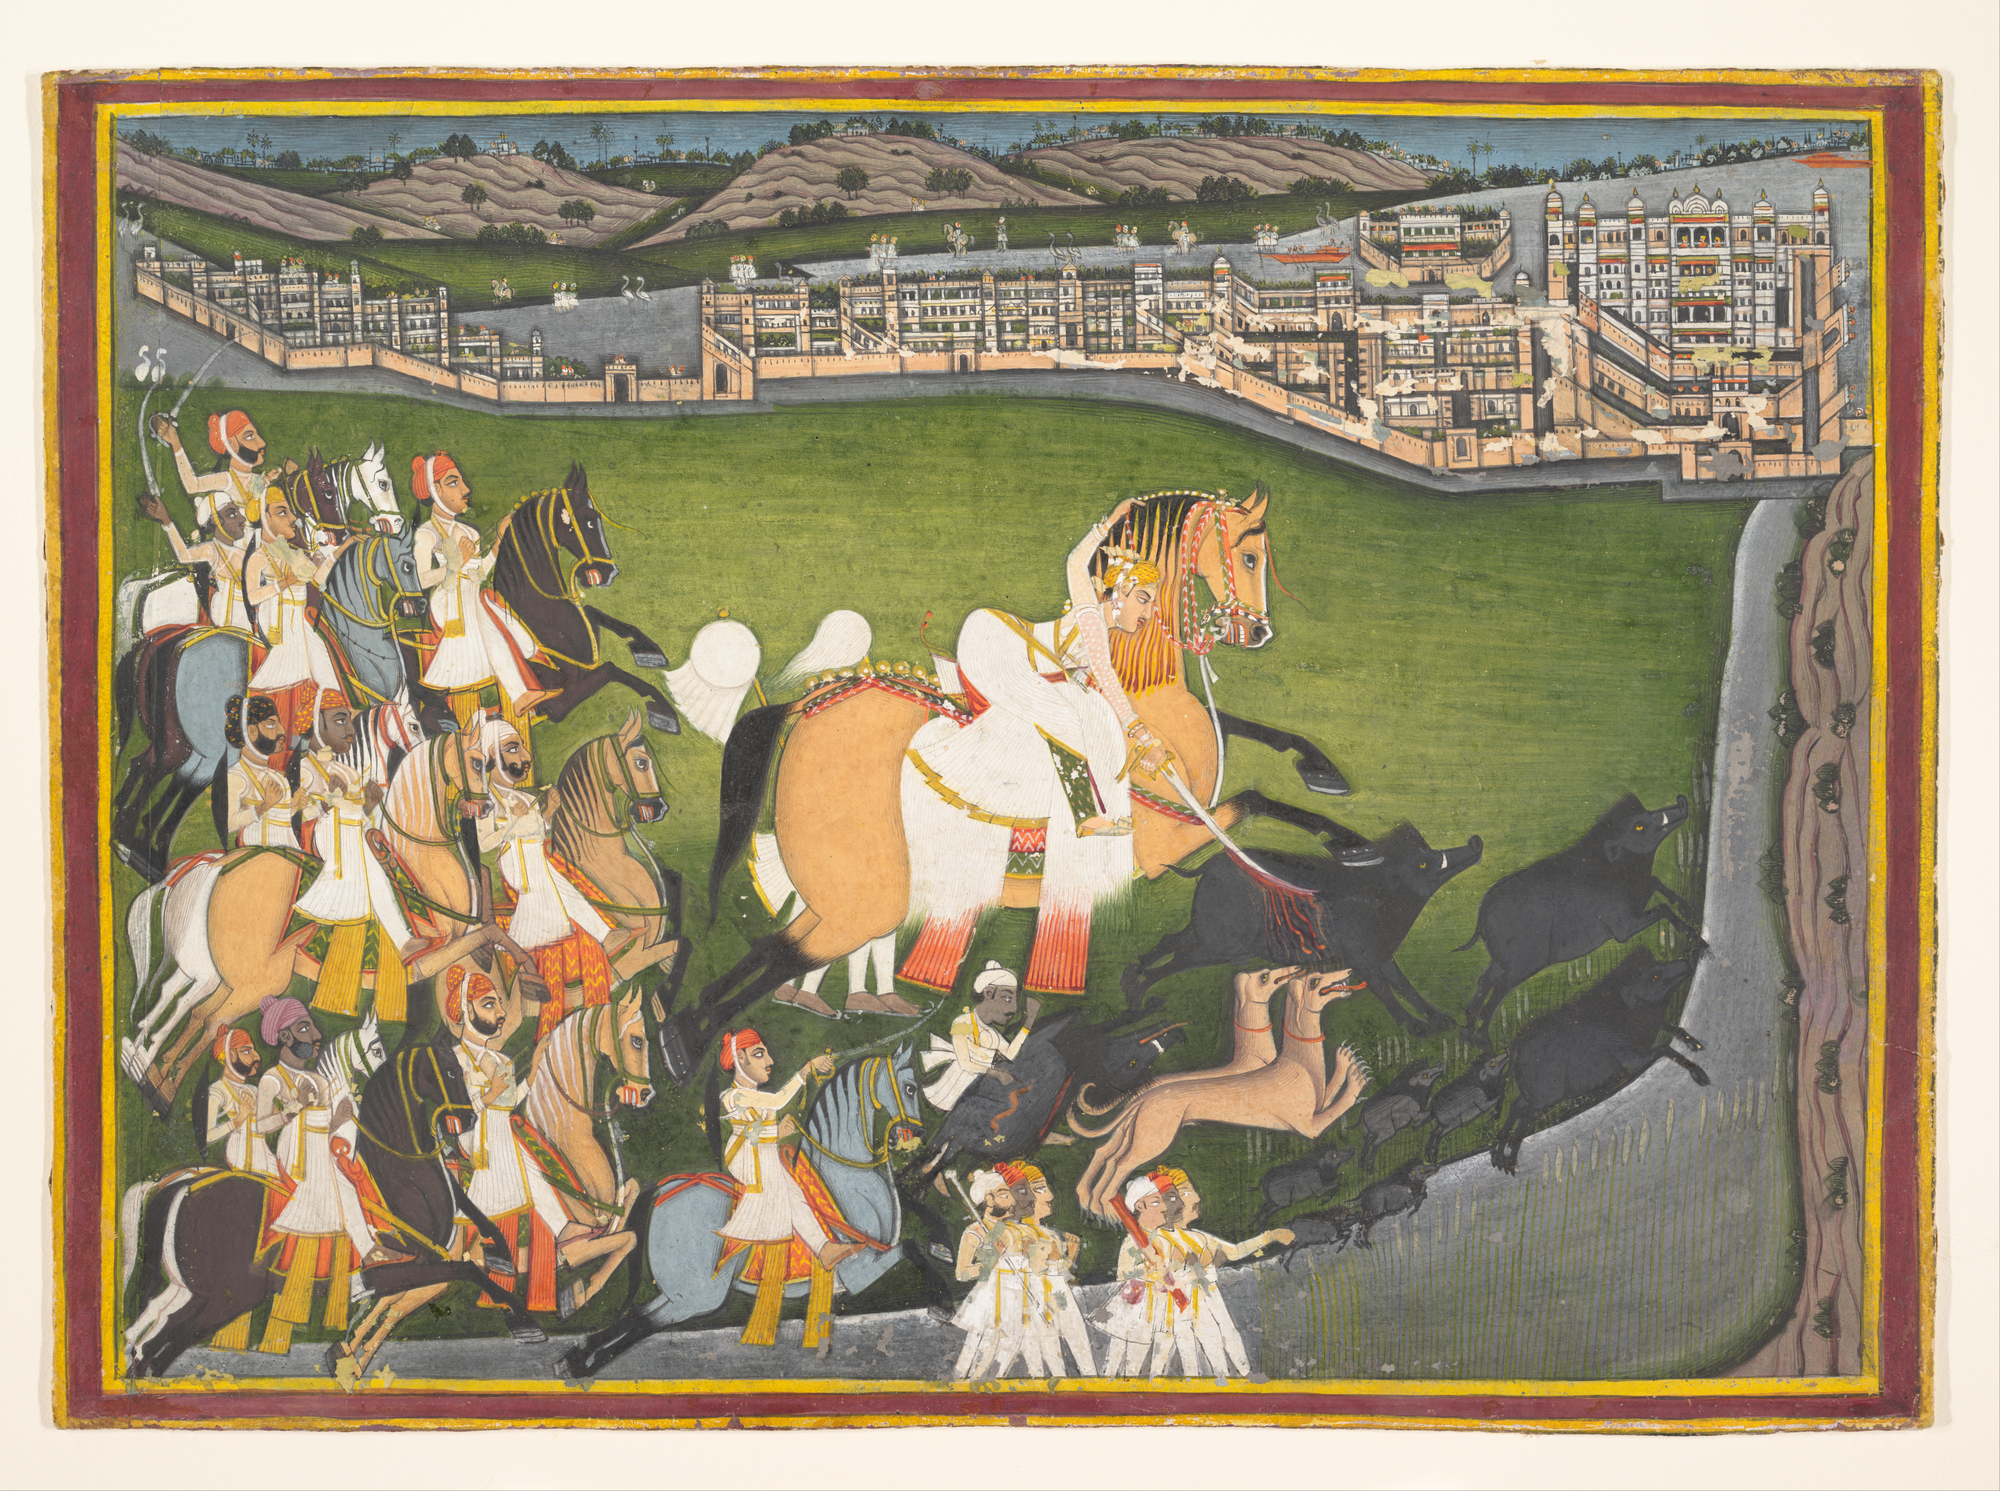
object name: painting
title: A Prince Hunting Boars with His Retinue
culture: western indian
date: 1767-1833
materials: gold, ink, paper, watercolor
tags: princes,men,hunting,boars,horses